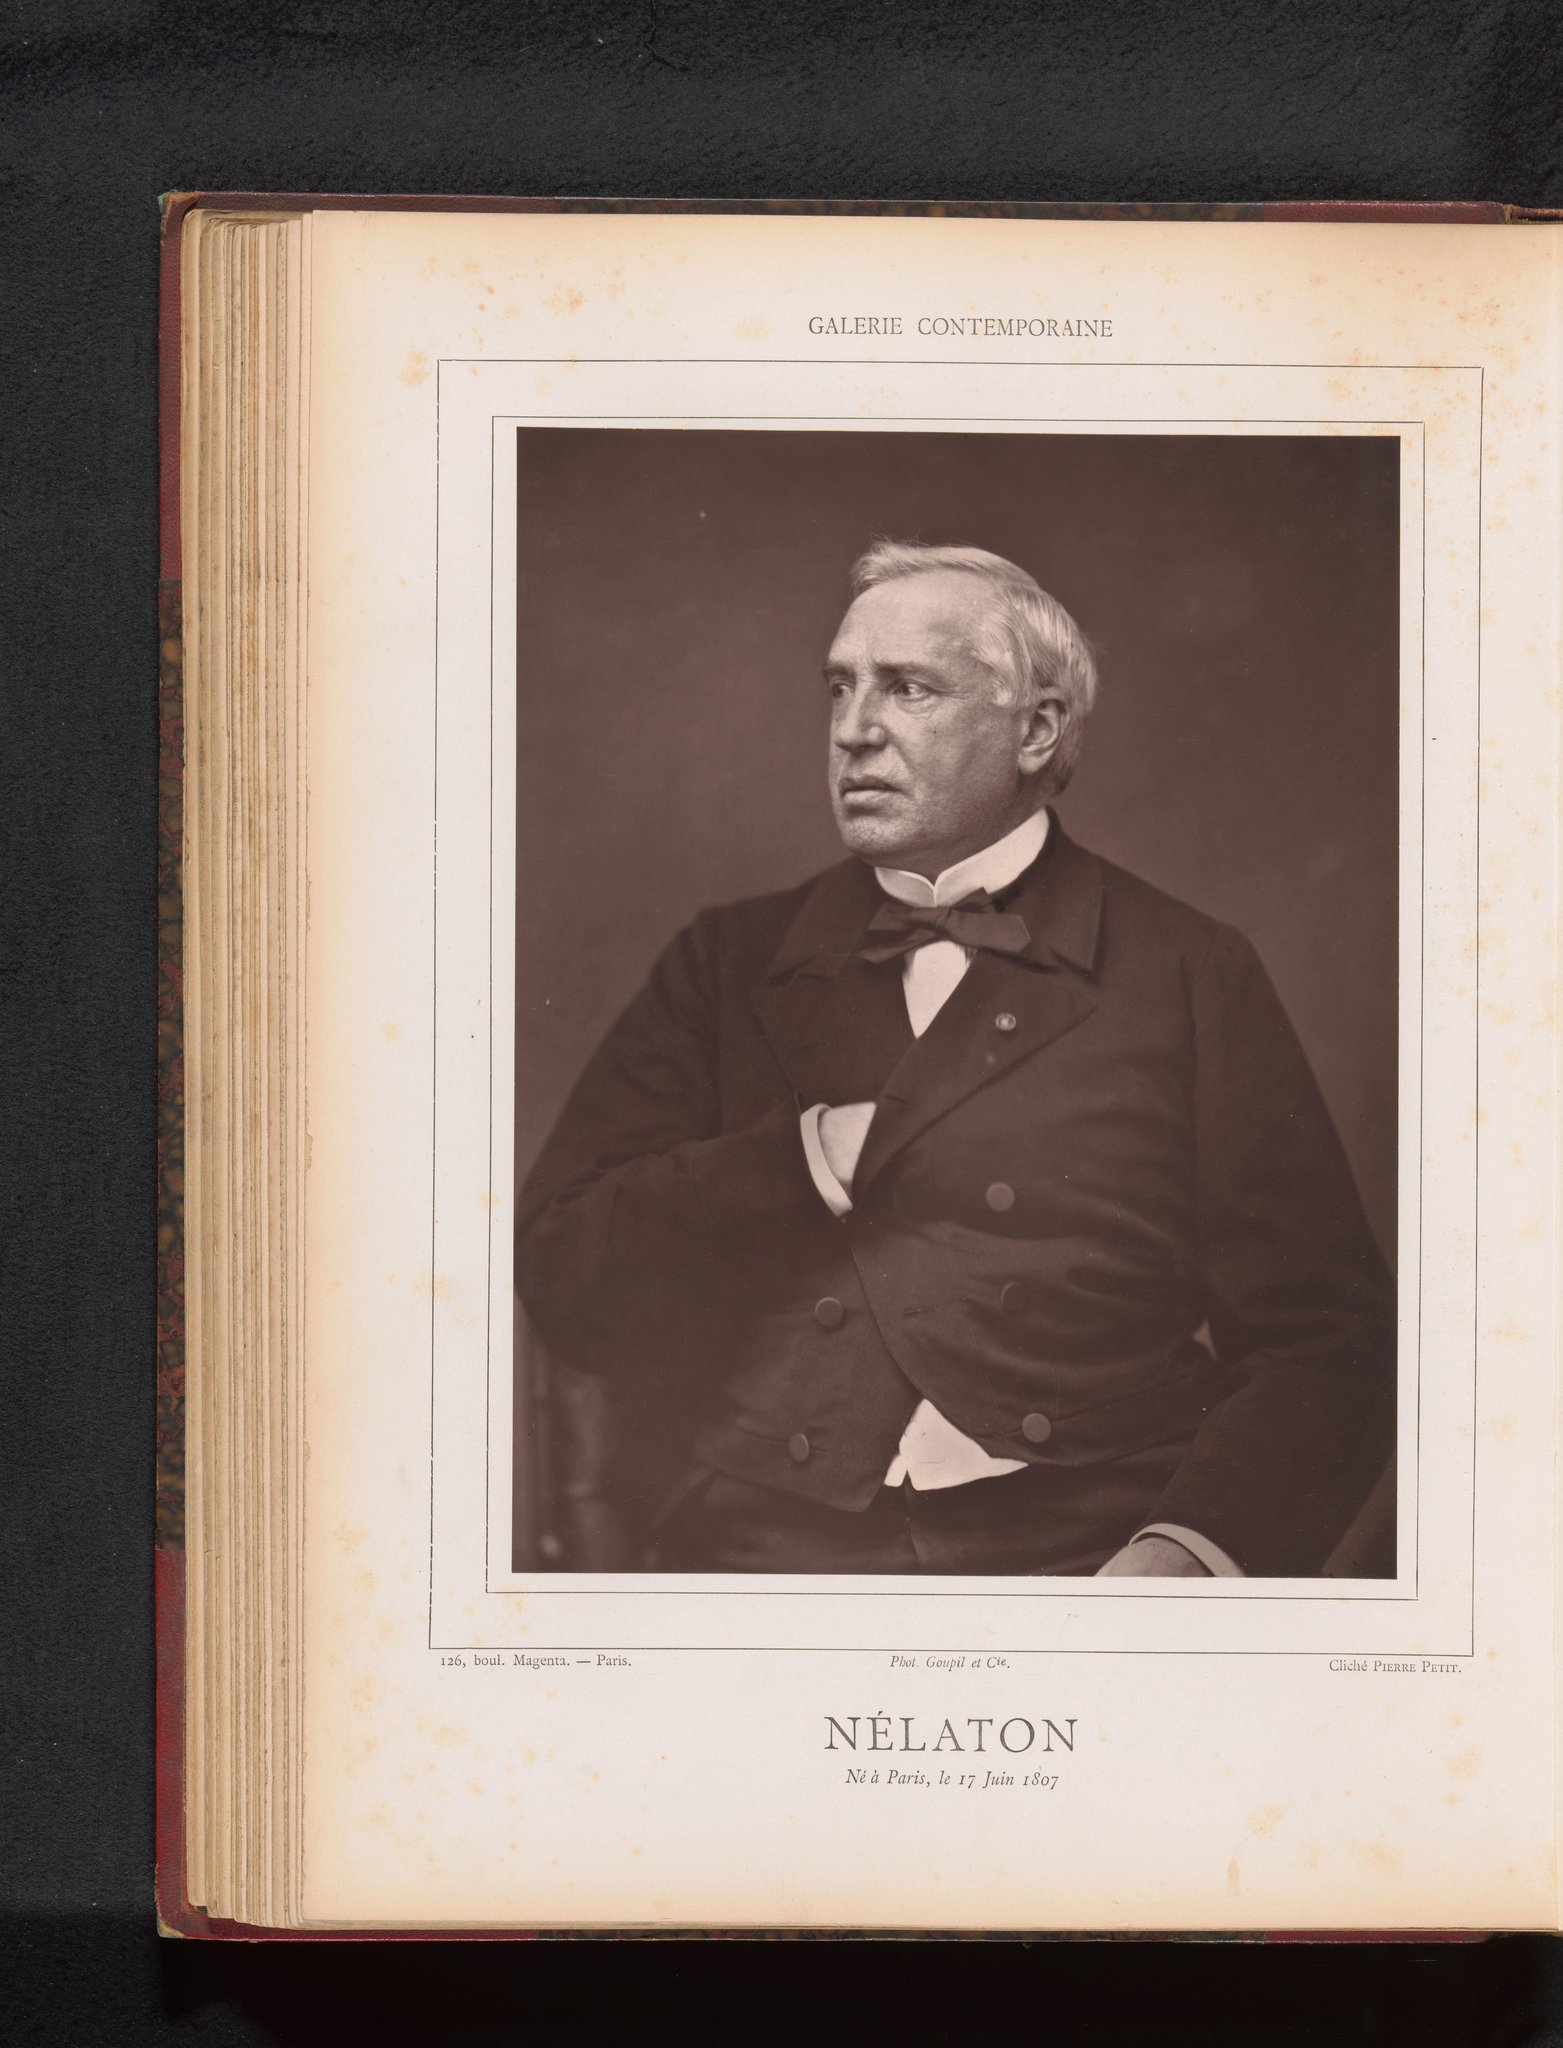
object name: page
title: Nélaton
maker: pierre petit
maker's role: fotograaf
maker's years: 1832-1909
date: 1873-1878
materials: paper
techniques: woodburytype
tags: paris, politician, historical persons, physician, doctor, politician, e.g. party leader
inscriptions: inscription: ‘Né à Paris, le 17 Juin 1807’